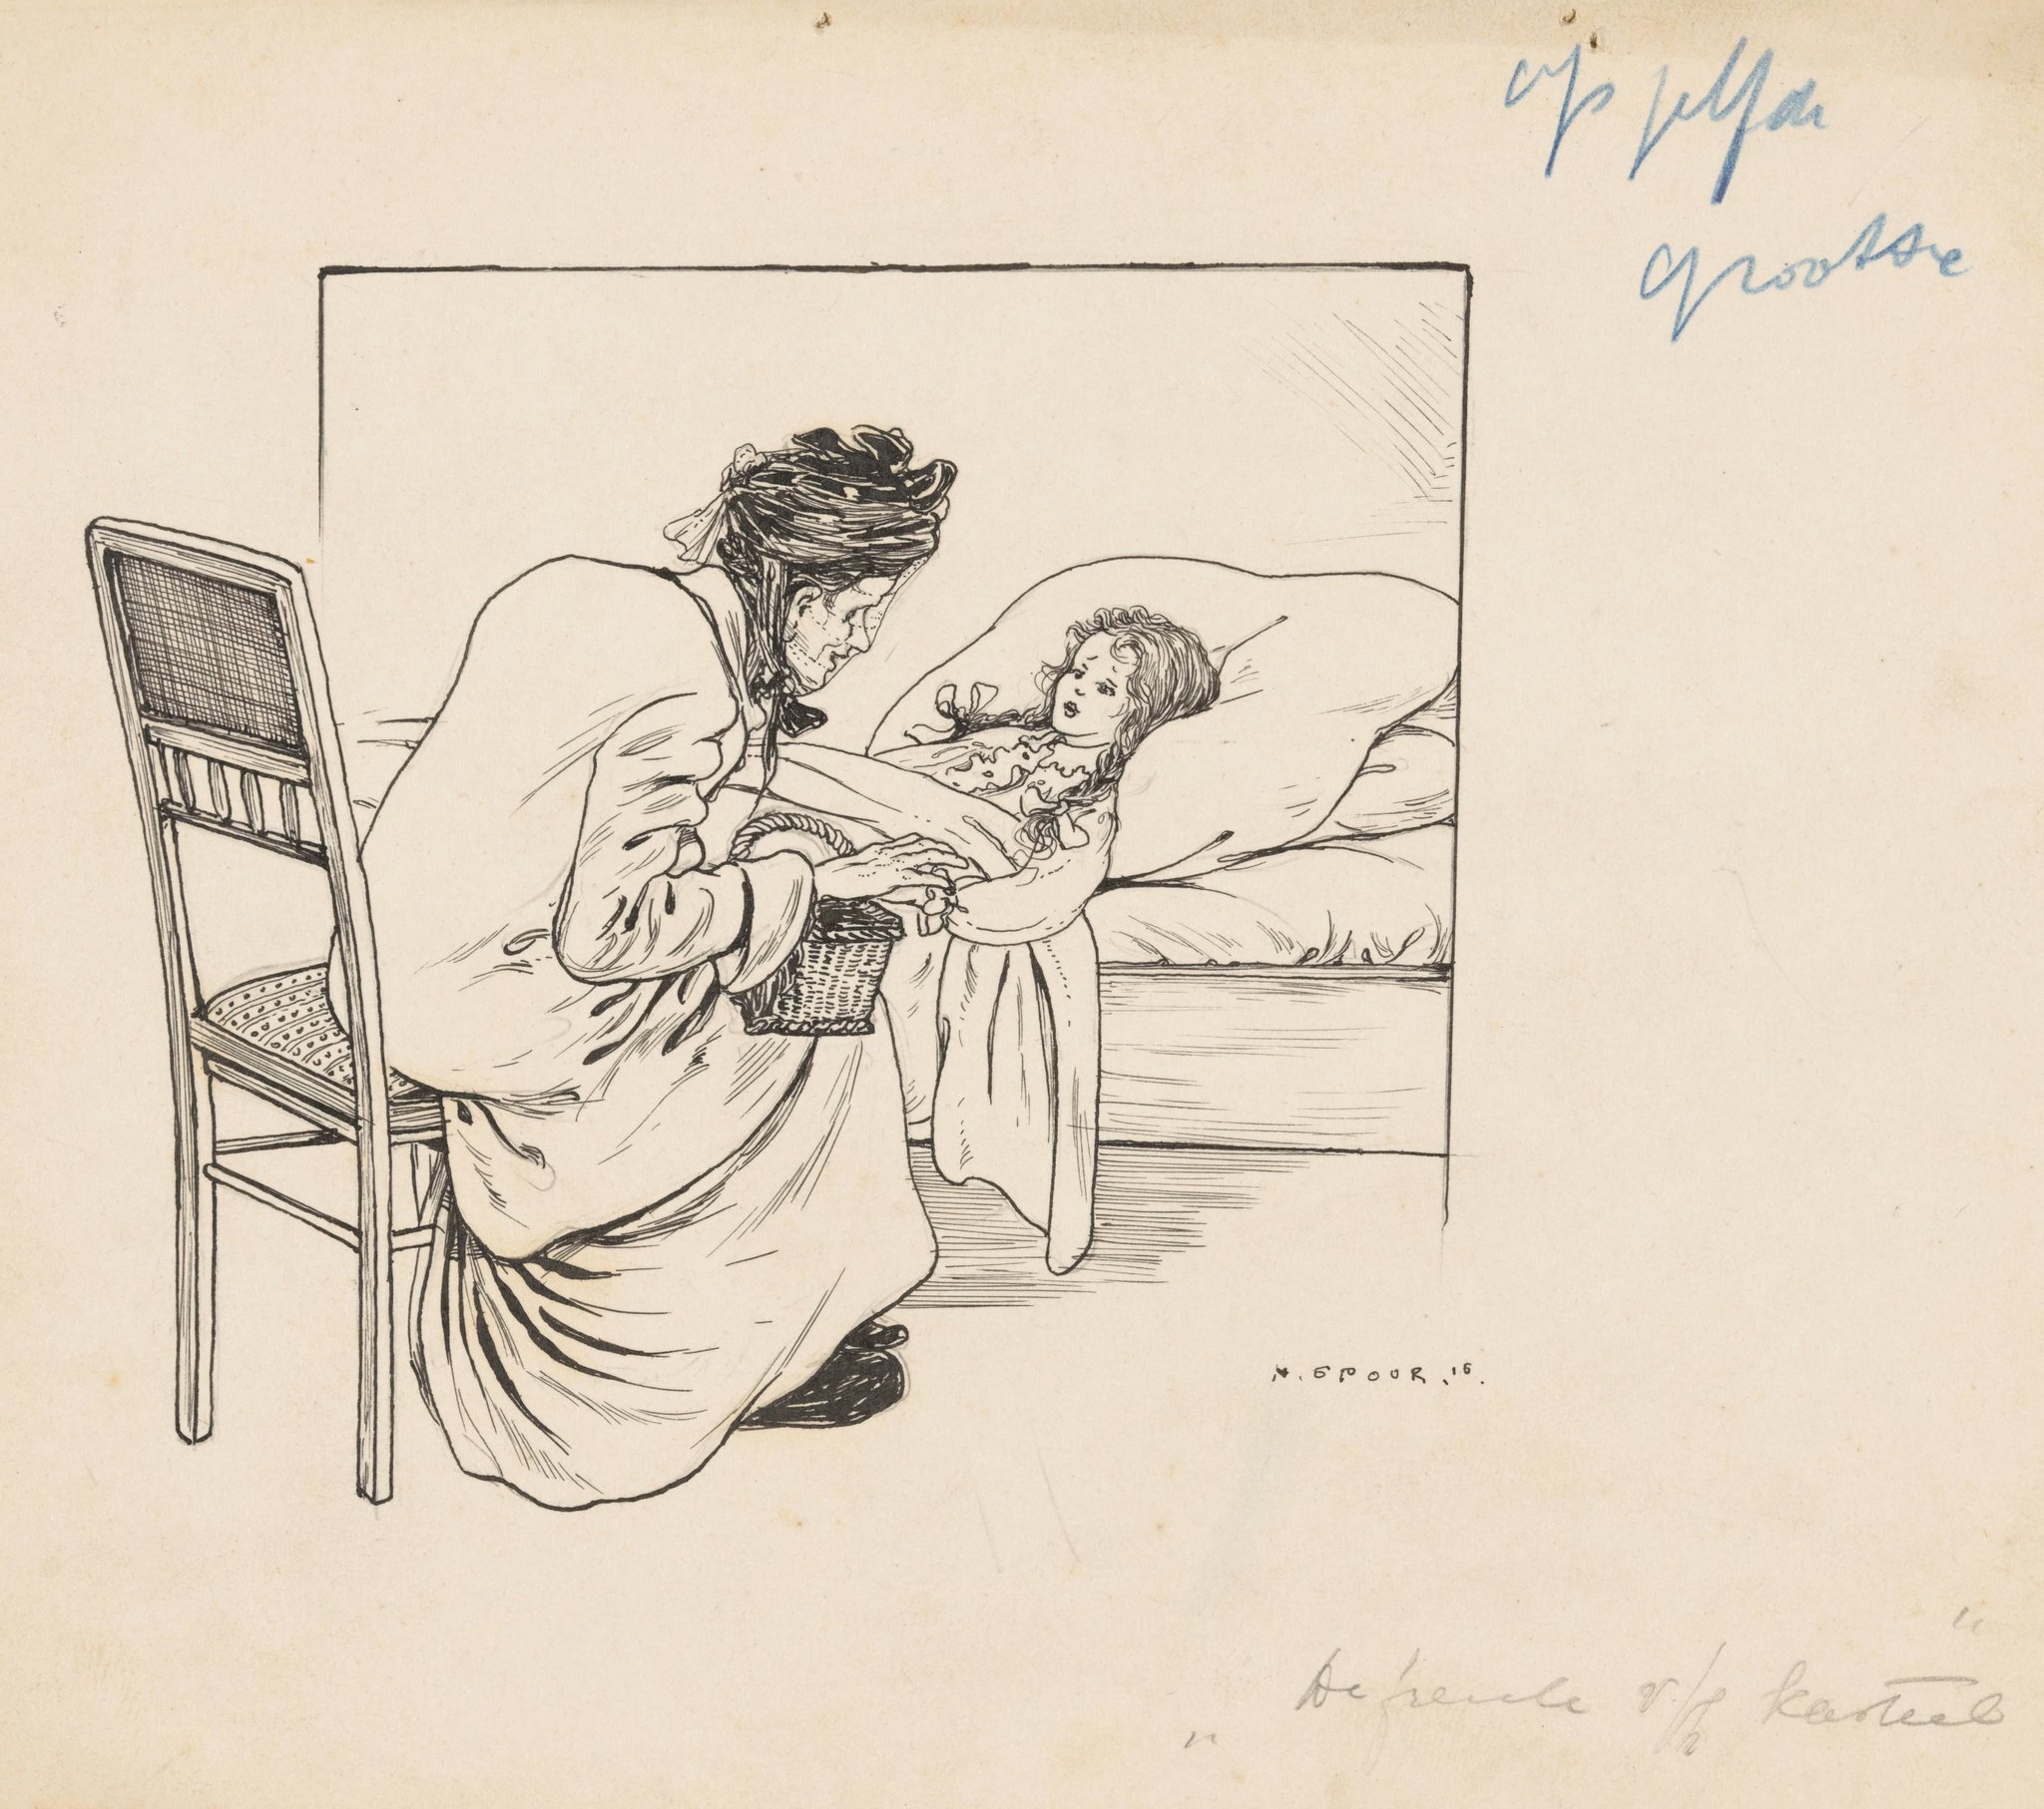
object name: boekillustratie ontwerp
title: Vrouw bij het ziekbed van een meisje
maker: nelly spoor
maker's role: draughtsman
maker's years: 1885-1950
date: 1916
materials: cardboard, ink, pencil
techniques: pen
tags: visiting the sick; sick person together with others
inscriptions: signature and date: ‘N. Spoor. 16’, collector's mark: Lugt 2228, :, annotation: ‘"De freule v/h kasteel"’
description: Een meisje ligt ziek op bed. Naast haar zit een vrouw op een stoel. Ze heeft een mand op schoot, draagt een hoed met een voile en buigt zich naar het meisje toe.